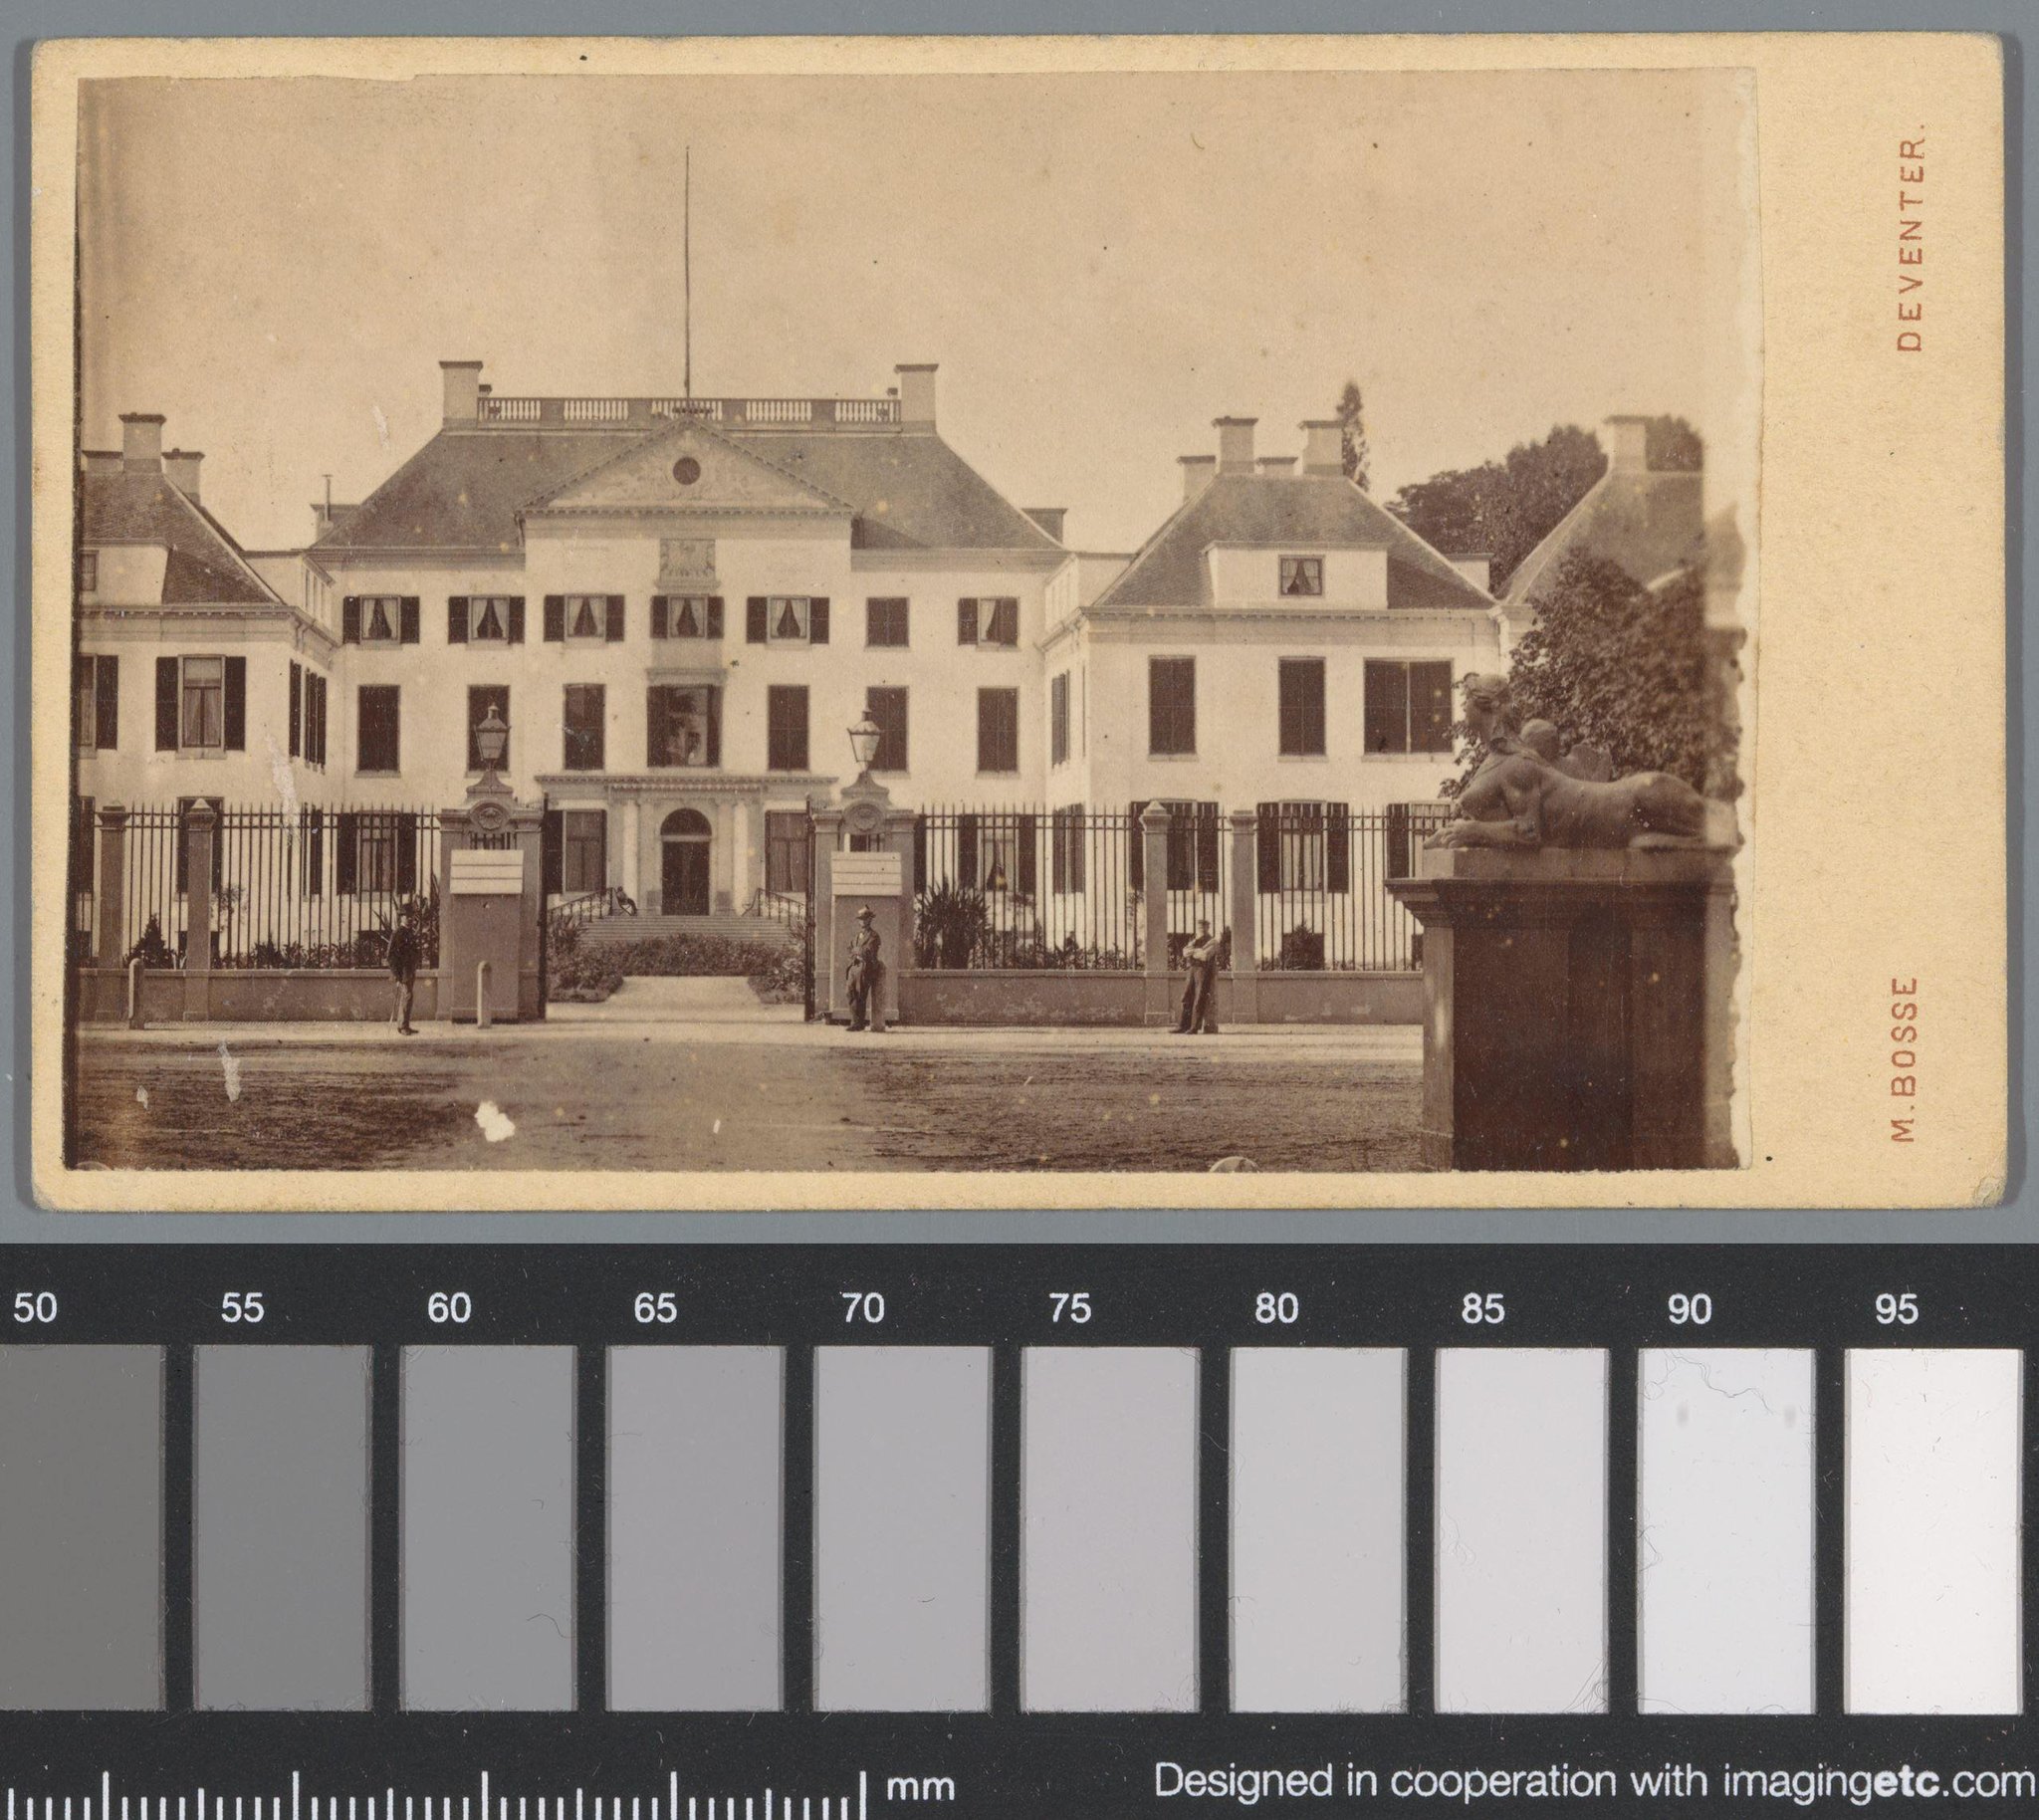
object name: carte de visite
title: Gezicht op een buitenhuis, vermoedelijk in de omgeving van Deventer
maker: johann heinrich martin bosse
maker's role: fotograaf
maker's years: 1838-1901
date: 1870-1894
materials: cardboard, photographic support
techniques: albumen print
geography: overijssel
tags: country-house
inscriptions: inscription: ‘M. BOSSE DEVENTER.’, inscription: ‘M.B./ Photogr.-Artist.-Atelier/ M. BOSSE/ Assenstraat en Bursesteeg/ DEVENTER./ Voor nabestellingen blijft de plaat bewaard./ Vergrootingen naar jeder klein portret./ tot levensgrootte.’